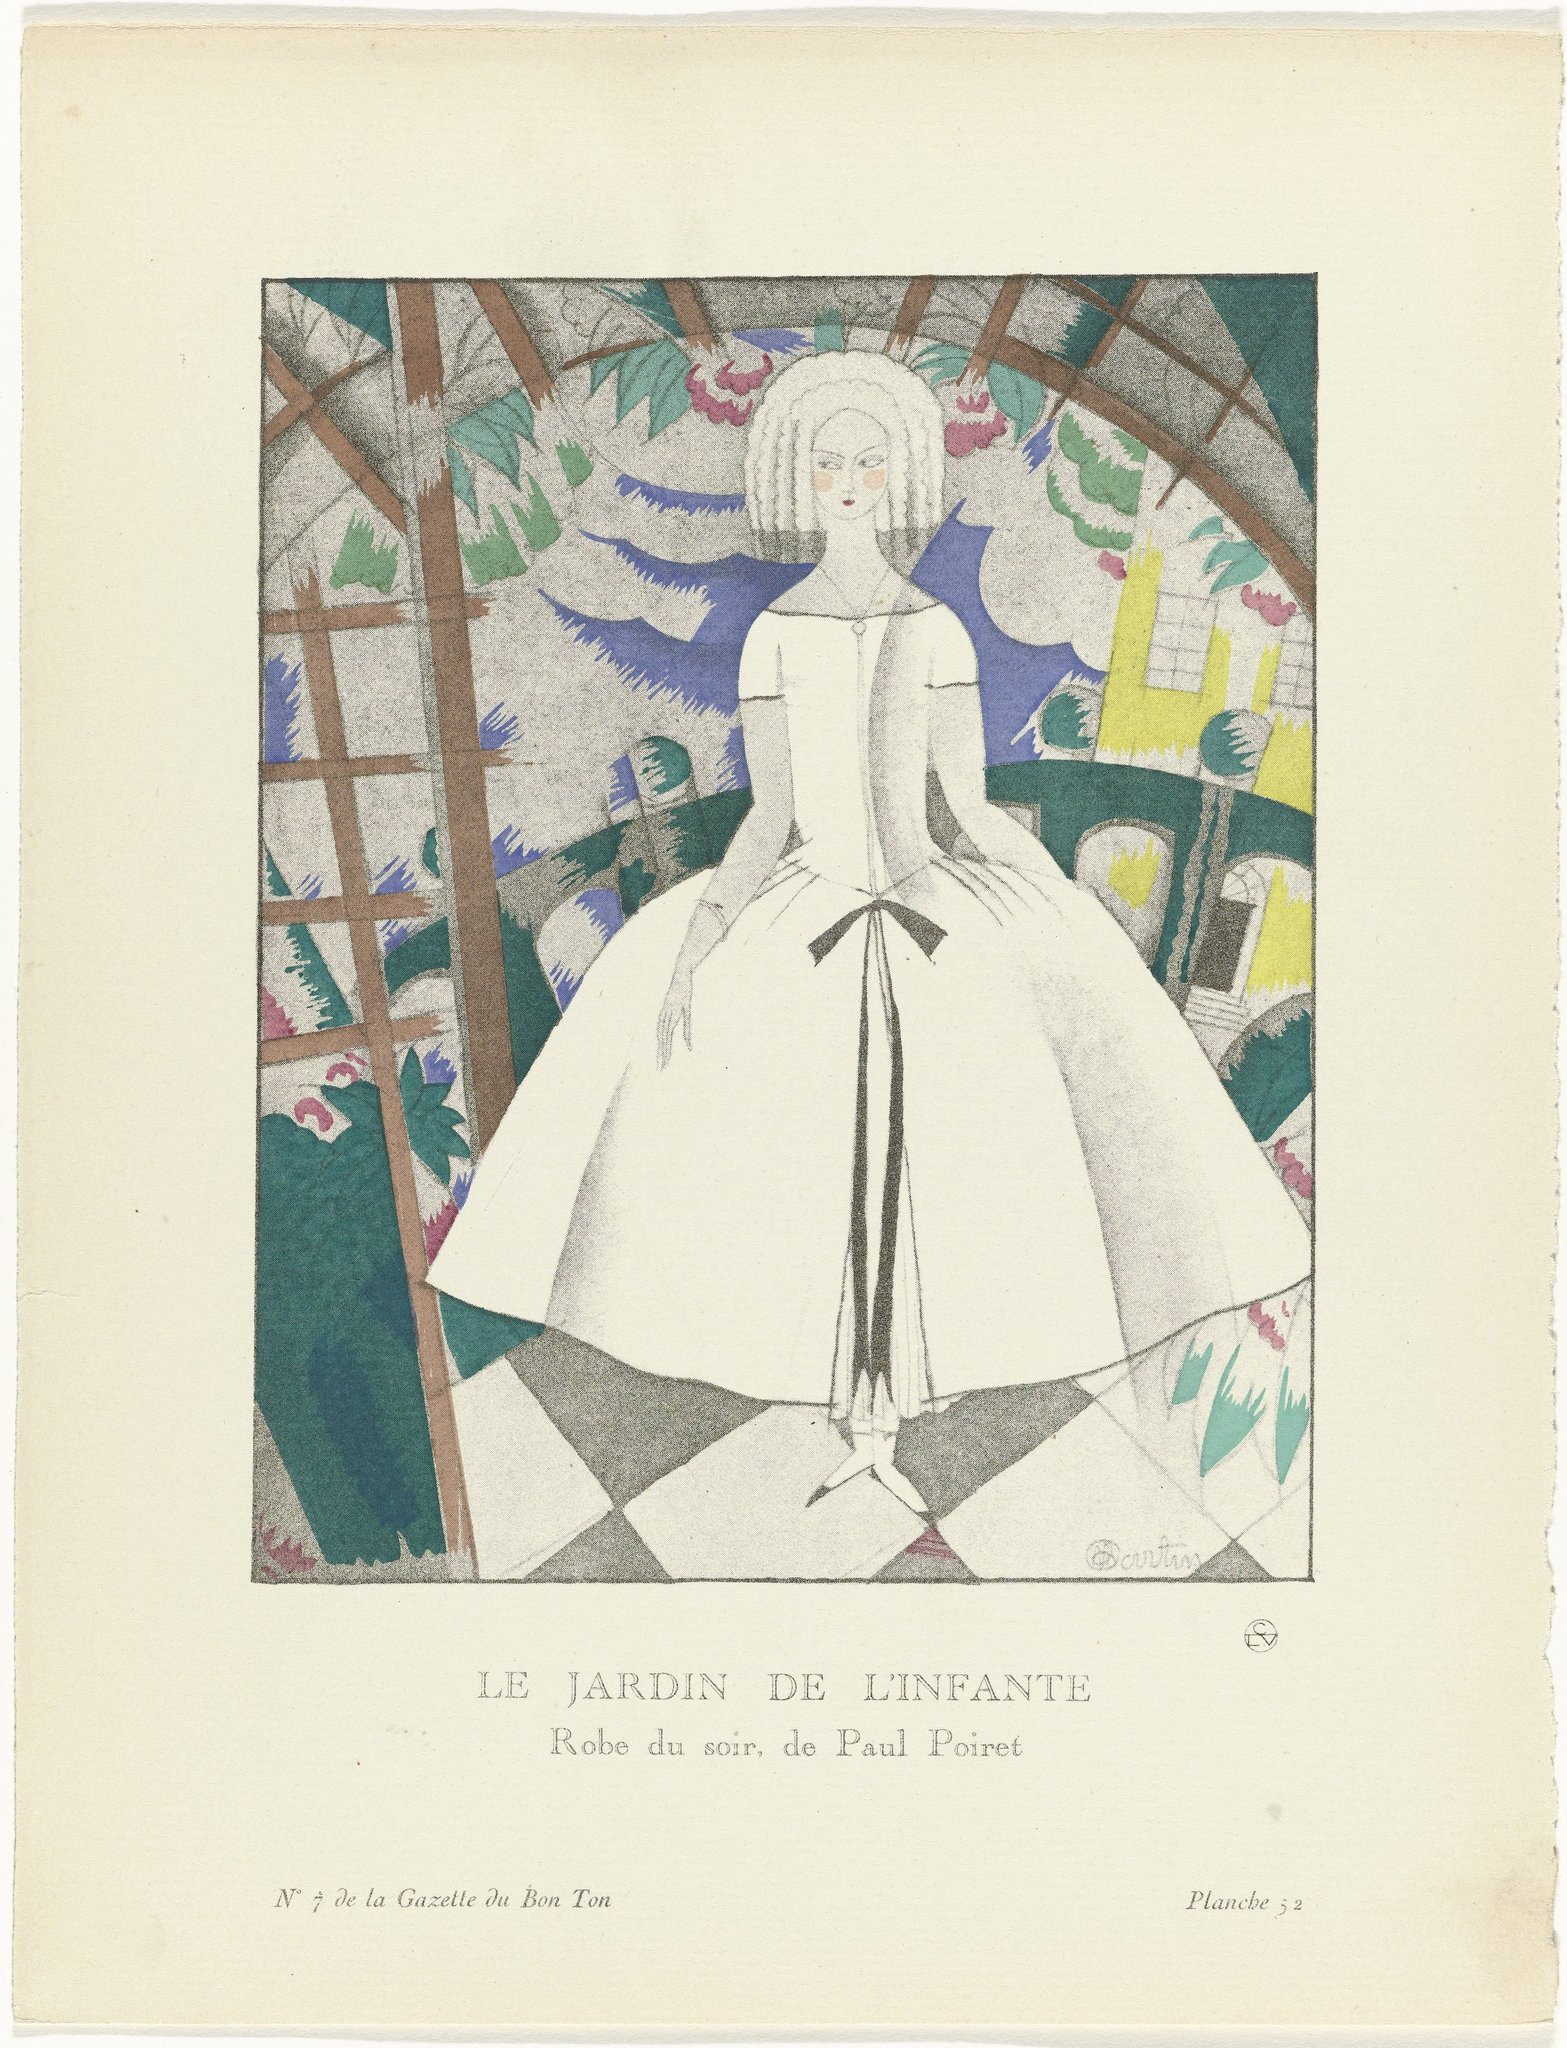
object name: fashion print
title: Gazette du Bon Ton, 1920 - No. 7, Pl. 52: Le jardin de l'infante / Robe du soir, de Paul Poiret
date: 1920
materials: paper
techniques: hand coloring, letterpress printing, photochemical processes, pochoir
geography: paris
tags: dress, gown: evening dress (+ women's clothes), garden, fashion plates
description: Vrouw op terras onder pergola, in wit satijnen avondjapon van Paul Poiret, afgezet met een zwart satijnen bies. Planche 52 uit Gazette du Bon Ton 1920, No. 7. Uitleg over de kleding op pagina "Explication des Planches".